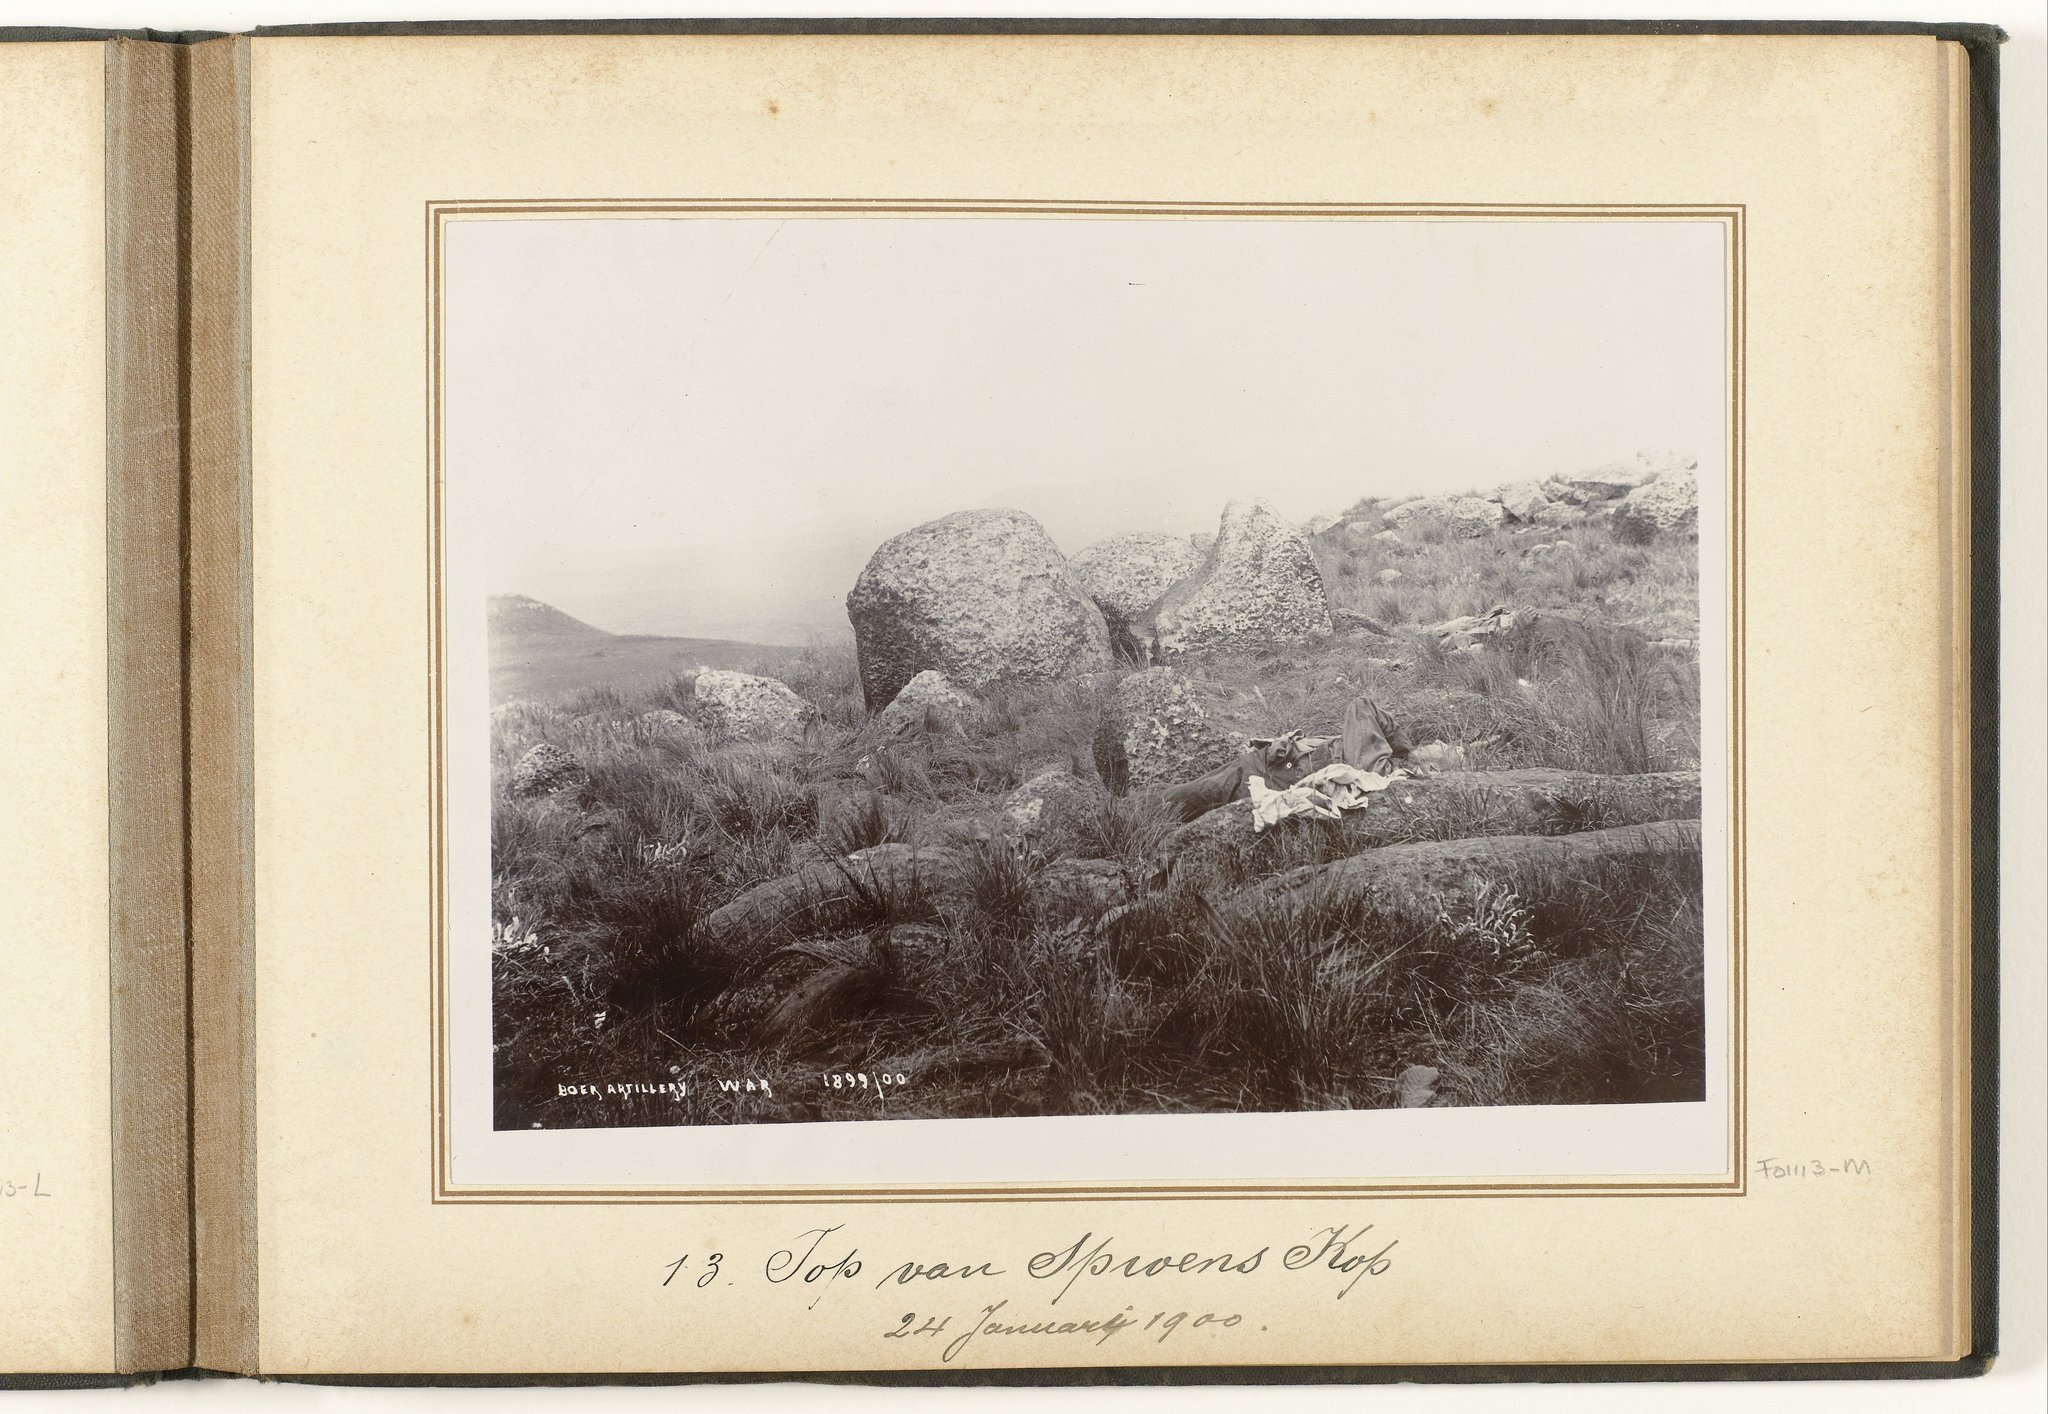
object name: album leaf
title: Boer artillery war 1899\00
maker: Anonymous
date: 1900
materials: cardboard, paper, photographic support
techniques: gelatin silver print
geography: spionkop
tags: horrors of war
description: Onderdeel van Fotoalbum met opnames van de Tweede Boerenoorlog (1899-1902).